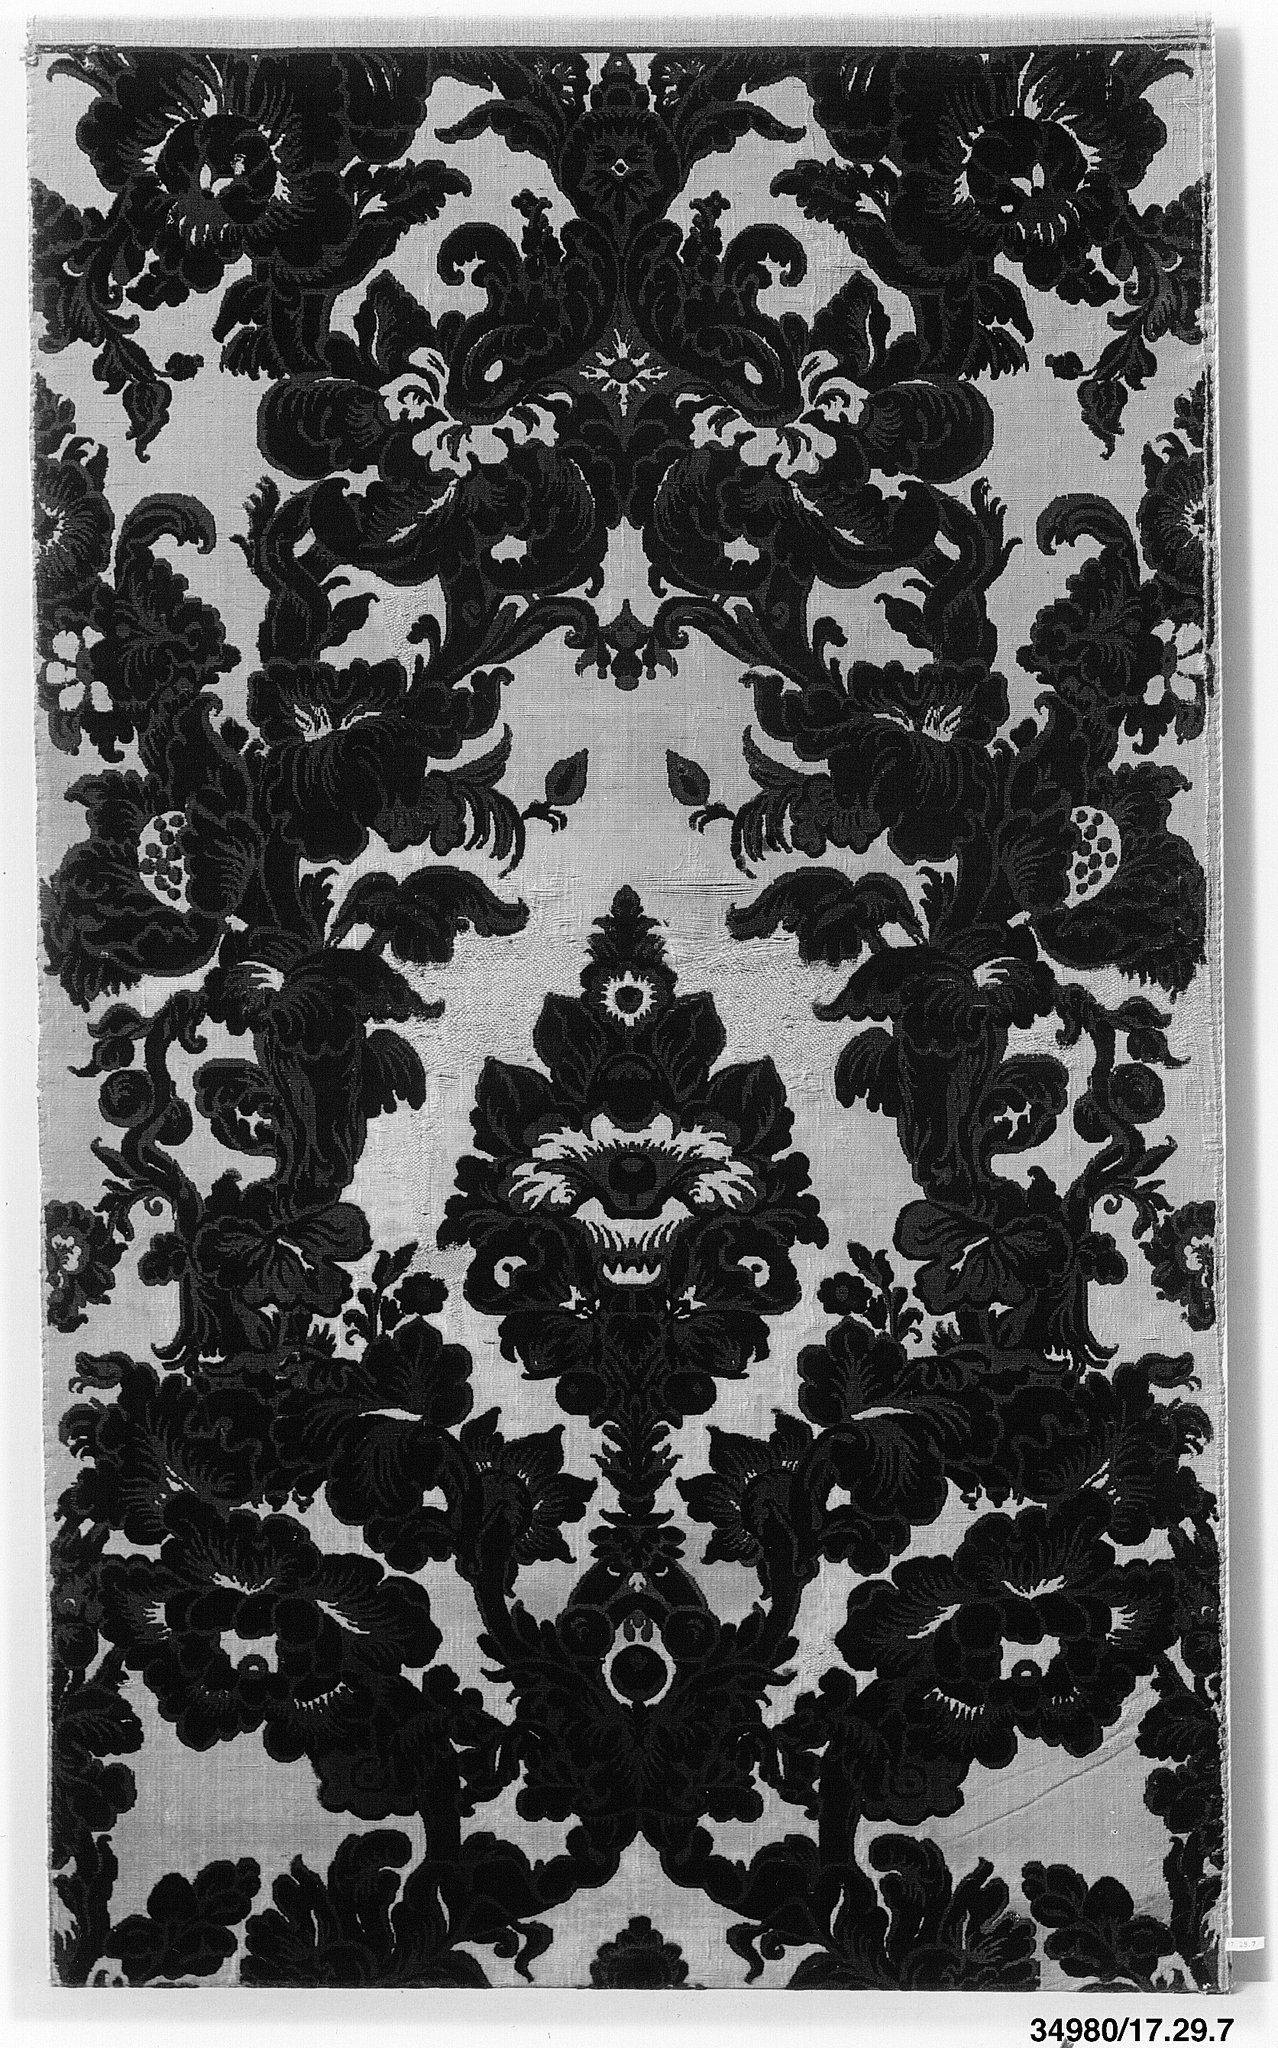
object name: piece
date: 1710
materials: metal thread, silk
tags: flowers,leaves